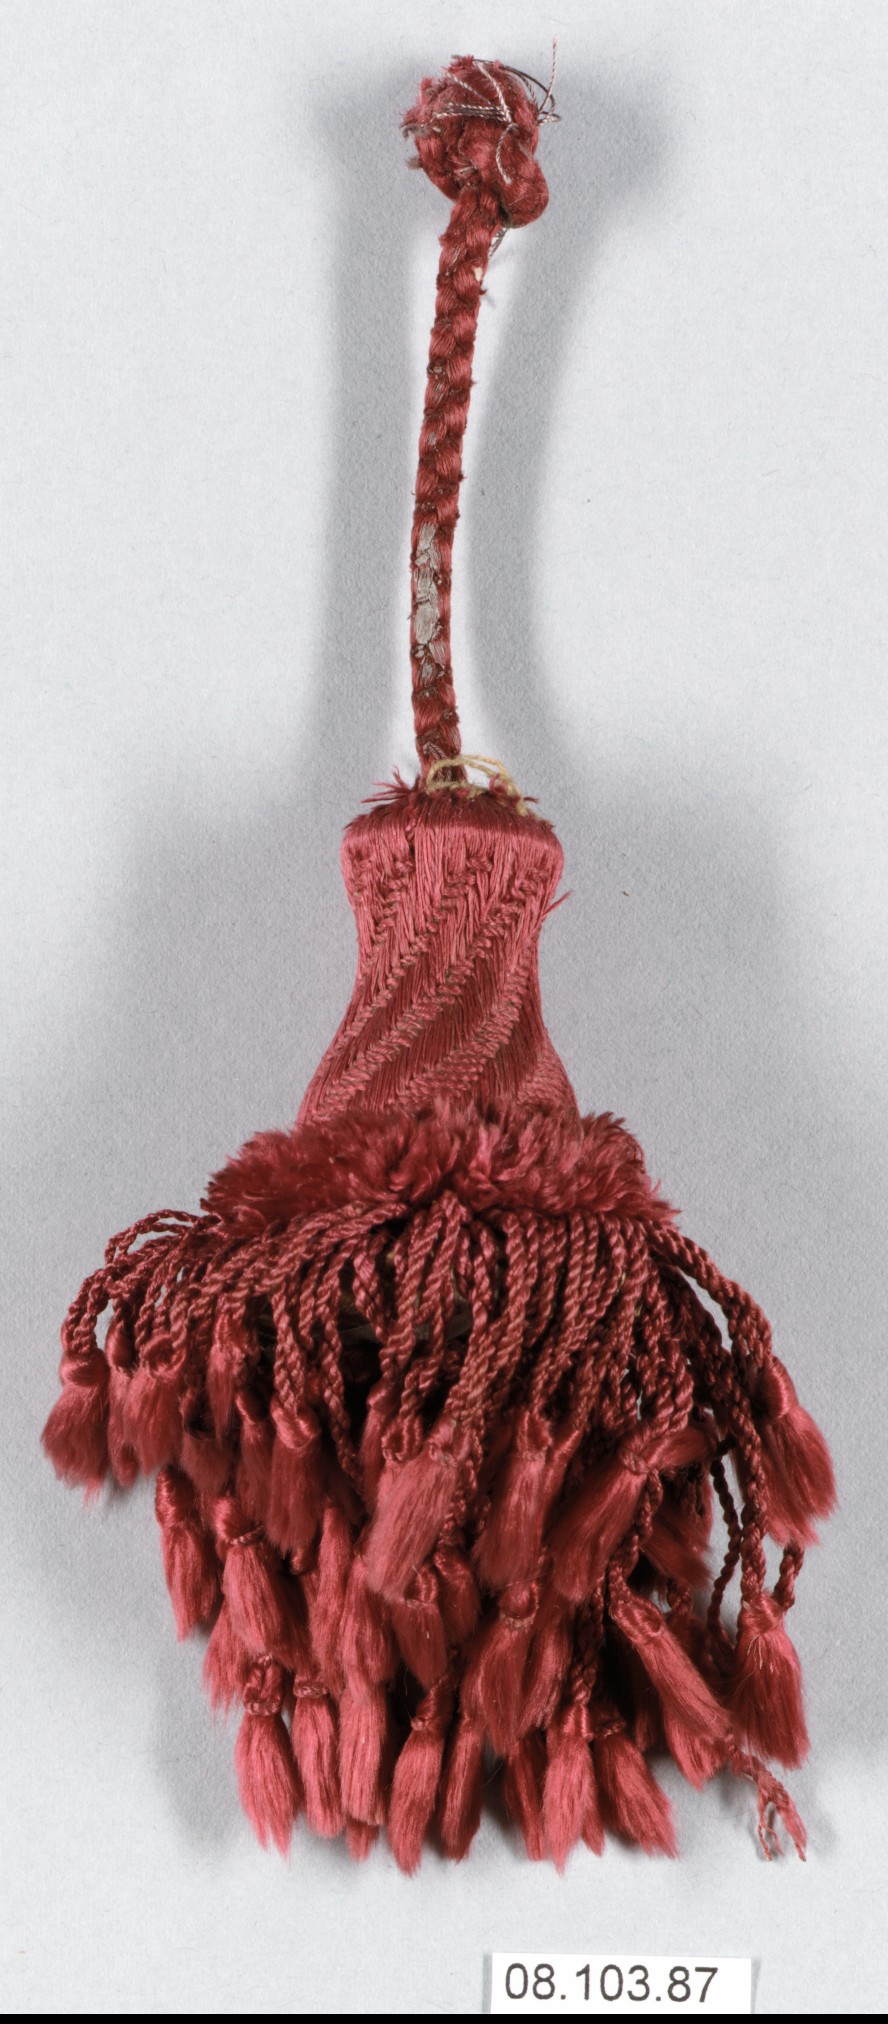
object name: tassel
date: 1567-1633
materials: silk